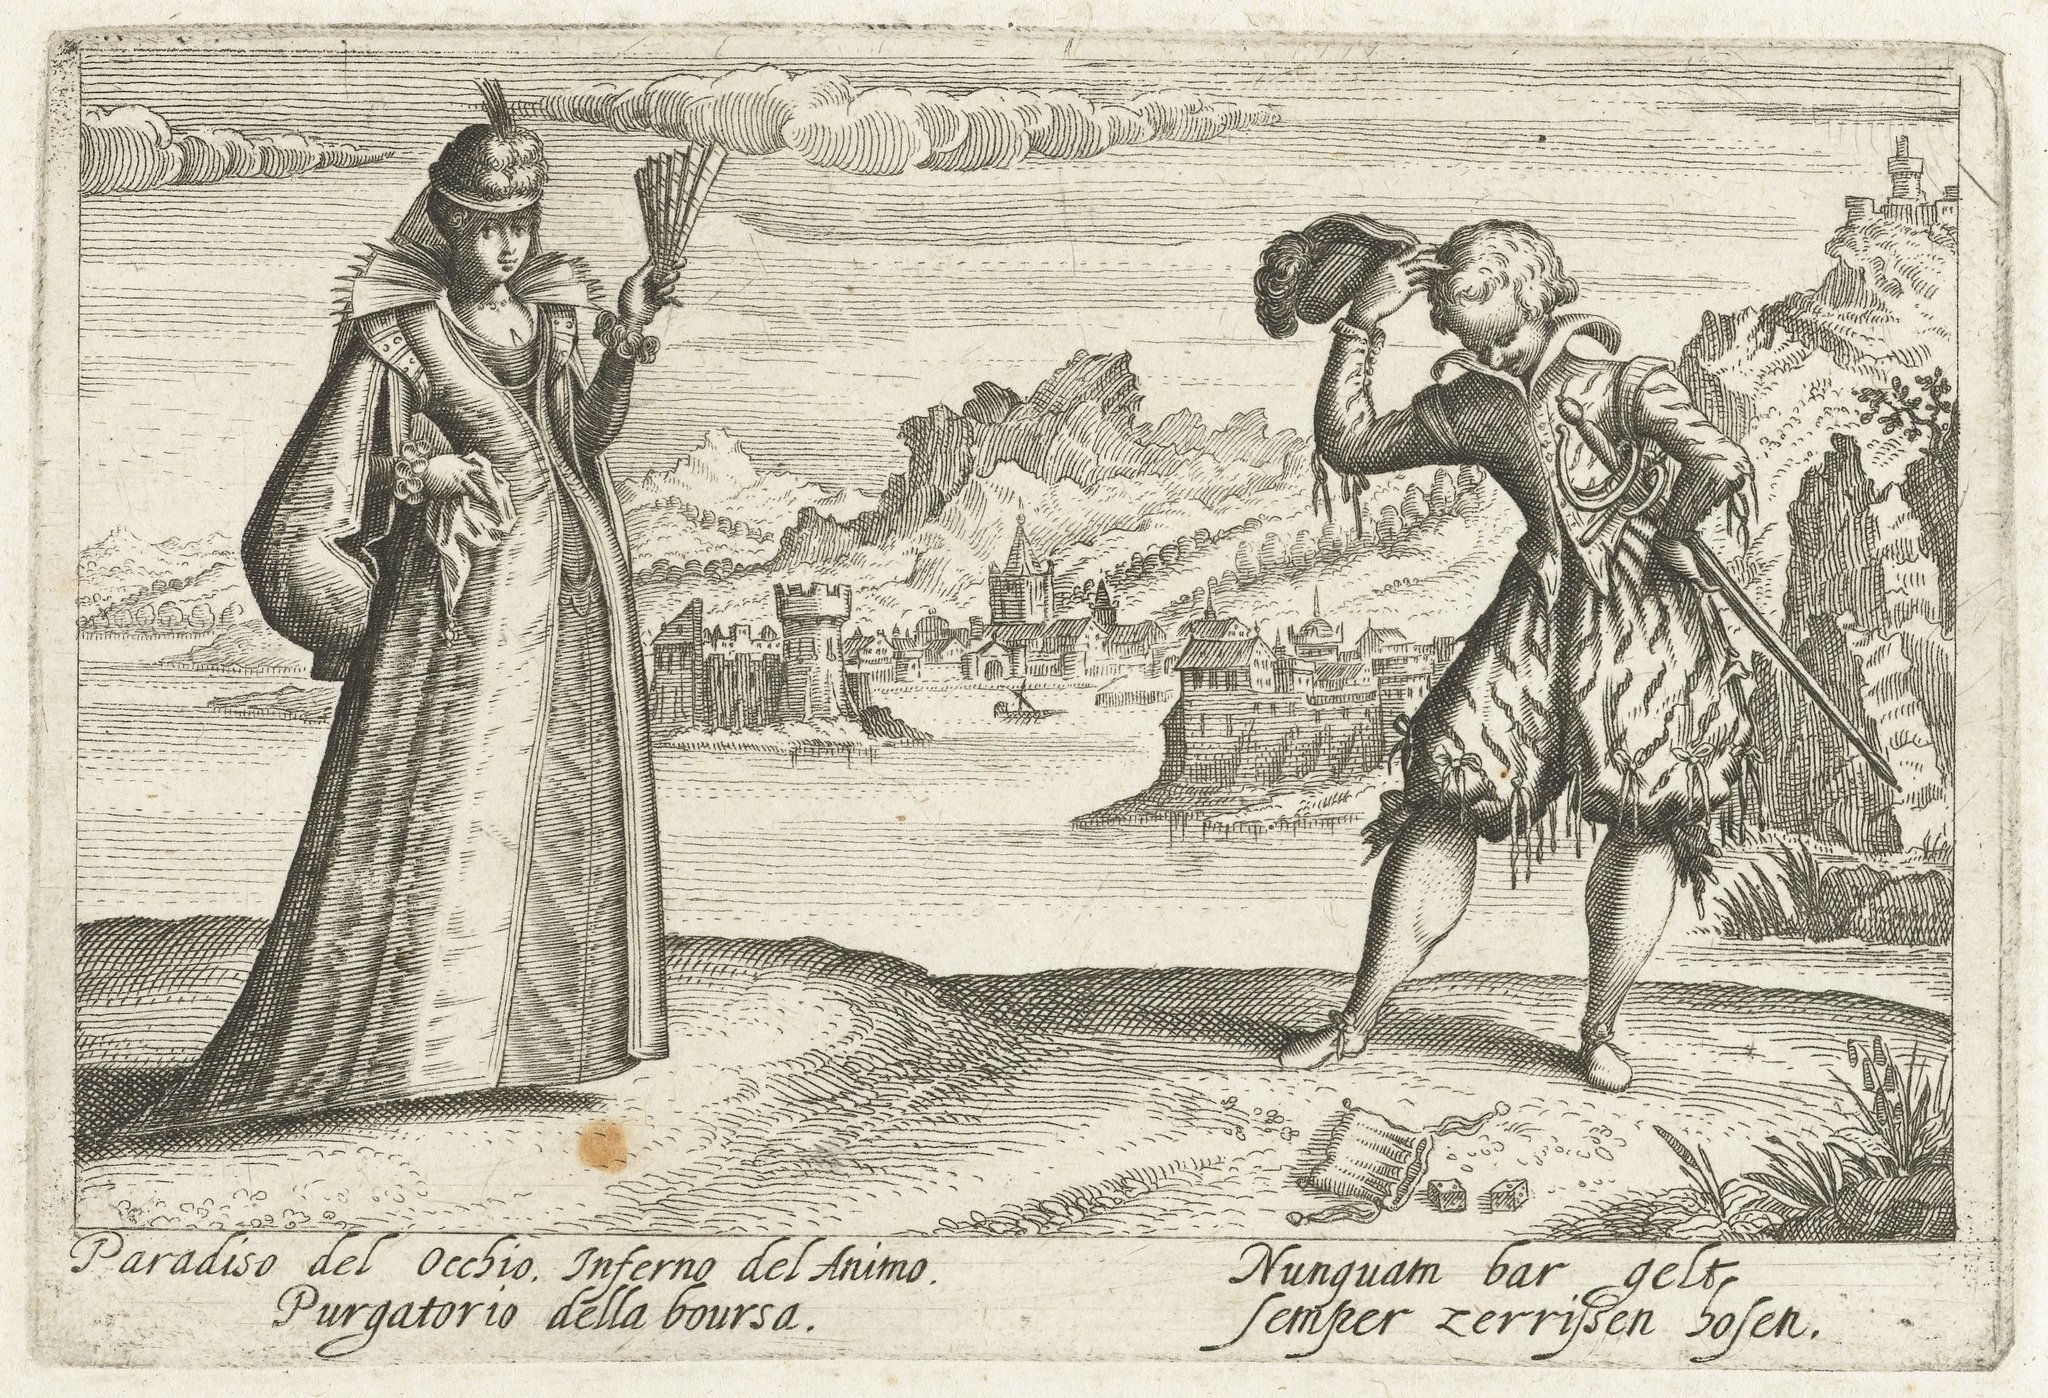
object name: print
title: Landschap met een man en vrouw in nette kledij, de man kijkt naar twee dobbelstenen op de grond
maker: jacob van der heyden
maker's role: draughtsman, print maker, publisher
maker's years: 1573-1645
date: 1608-1618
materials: paper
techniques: engraving, etching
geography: straatsburg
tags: purse, money-bag, 'album amicorum', 'stammbuch', clothes, costume (+ women's clothes), fan, clothes, costume (+ men's clothes), dice-games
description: Deze serie, getiteld ‘Pugillus facetiarum iconographicarum in studiosorum (…)’, bestond vermoedelijk uit 36 of meer prenten. Van deze serie zijn in ieder geval twee uitgaven bekend, uit 1608 en 1618. De prenten uit deze serie in de collectie van het Rijksmuseum (RP-P-1996-1 t/m RP-P-1996-36) zijn vermoedelijk afkomstig uit verschillende uitgaven, of uit de tweede uitgave. De inhoud van beide uitgaven verschilt, maar om de precieze inhoud van de verschillende uitgaven vast te stellen is meer onderzoek nodig. Er zijn geen volledige exemplaren van de eerste uitgave bekend. Aan de hand van de analyse van een andere serie, ‘Jeucht spieghel’,* die kopieën van ‘Pugillus’ bevat en is uitgegeven in 1610 én de aanwezige exemplaren van prenten uit ‘Pugillus’ in een inmiddels verloren album amicorum uit 1610,** kan in ieder geval van een aantal prenten gesteld worden dat ze al voorkwamen in de uitgave van 1608. Dit geldt voor RP-P-1996-1 (de titelprent), RP-P-1996-5, RP-P-1996-6, RP-P-1996-7, RP-P-1996-8, RP-P-1996-9, RP-P-1996-10, RP-P-1996-11, RP-P-1996-12, RP-P-1996-13, RP-P-1996-14, RP-P-1996-15, RP-P-1996-16, RP-P-1996-17, RP-P-1996-18, RP-P-1996-19, RP-P-1996-24, RP-P-1996-28, RP-P-1996-29, RP-P-1996-33 en RP-P-1996-35. Van één prent (RP-P-1996-31) kan vastgesteld worden dat die pas in de latere uitgave van 1618 voorkwam, omdat het kopie is van een prent uit weer een andere serie, ‘Academia sive speculum vitae scholasticae (…)’, die werd uitgegeven in 1612.*** Van de huidige prent is onduidelijk of hij al voorkwam in de uitgave van 1608. * Z.G.H.P.H.S [Zacharias Heyns]. Jeucht spieghel. S.l.s.n., 1610. Voor een gedigitaliseerd exemplaar zie: https://archive.org/details/ned-kbn-all-00000628-001/page/n9/mode/2up. ** Zie: Erman, Wilhelm en Ewald Horn. Bibliographie der deutschen Universitäten, systematisch geordnetes Verzeichnis der bis Ende 1899 gedruckten Bücher und Aufsätze über das deutsche Universitätswesen. Leipzig en Berlijn: Verlag von B.G. Teubner, 1904, dl. 1, p. 826-832, no. 17328. https://archive.org/details/bibliographieder01ermauoft/page/826/mode/2up *** Passe, Crispijn van de (I). Academia sive speculum vitae scholasticae (…). Arnhem: Johannes Janssonius [Jan Jansz.], 1612. Voor een gedigitaliseerd exemplaar zie: http://gallica.bnf.fr/ark:/12148/btv1b55005974h.